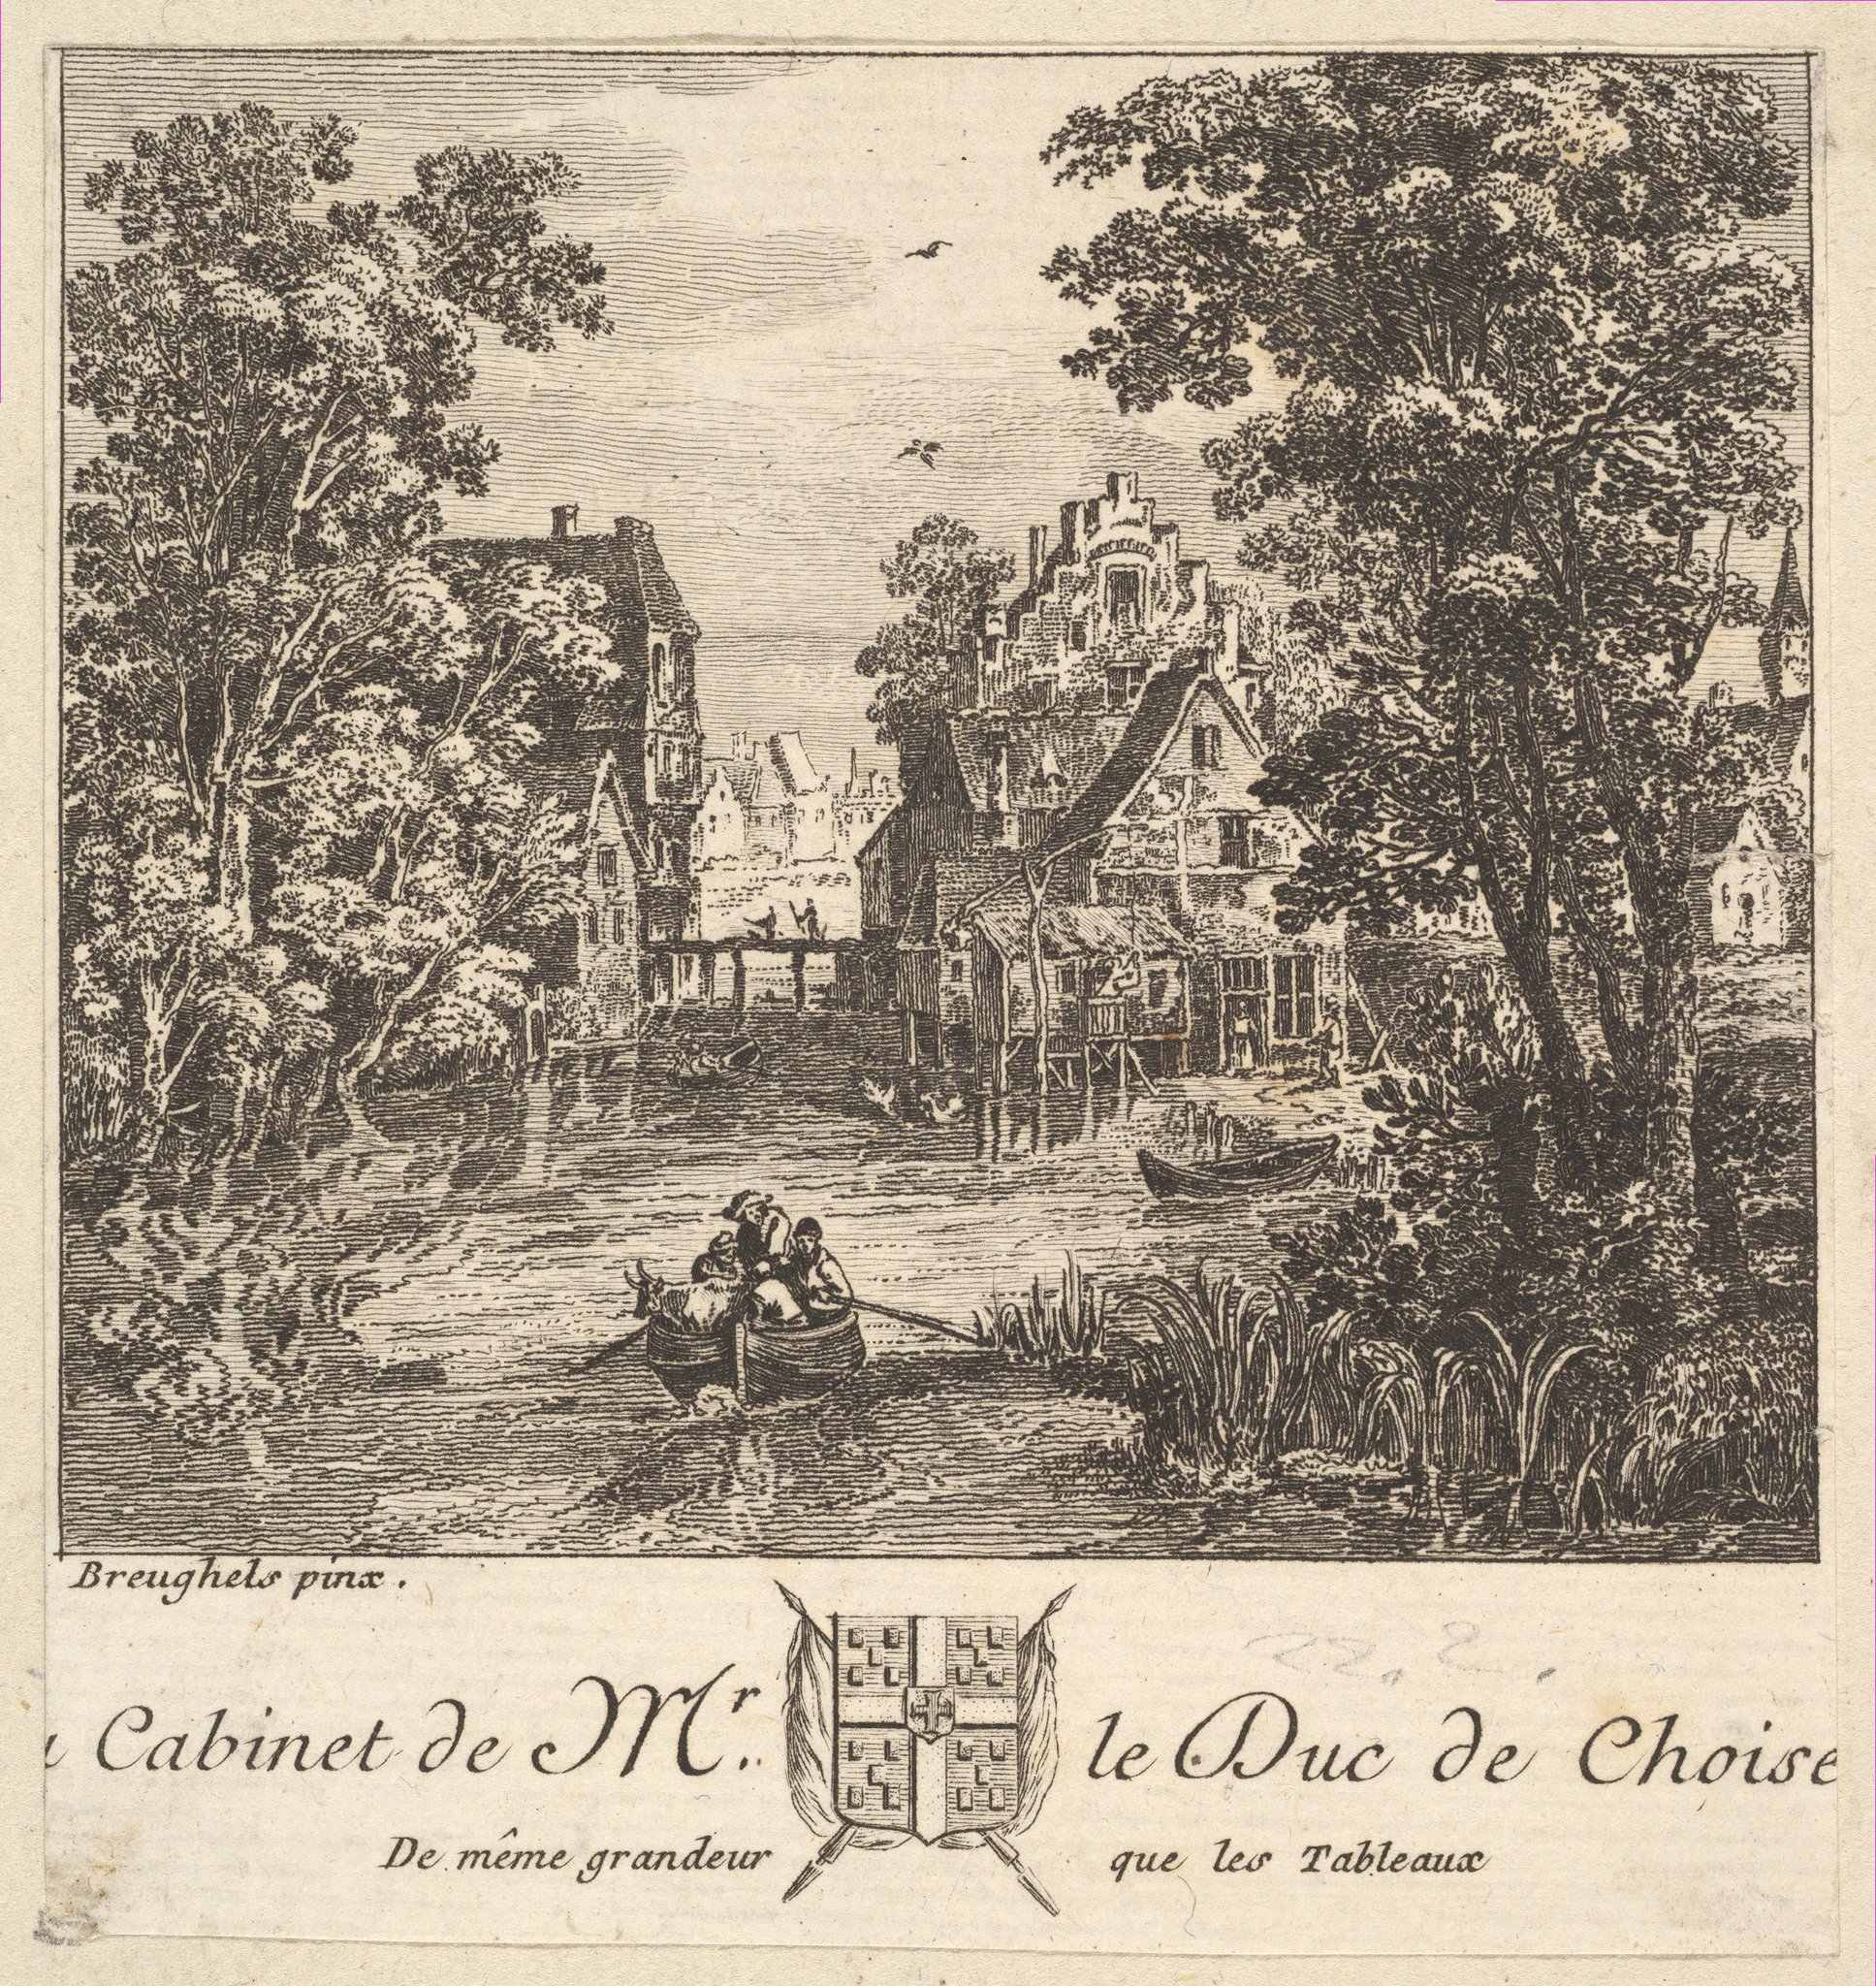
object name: print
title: Boat on a River near a Town after a painting in the cabinet of the Duc de Choiseul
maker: anonymous, french, 18th century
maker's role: artist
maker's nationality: french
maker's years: 1700-1800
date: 1700-1790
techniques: engraving, etching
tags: towns,rivers,insignia,boats